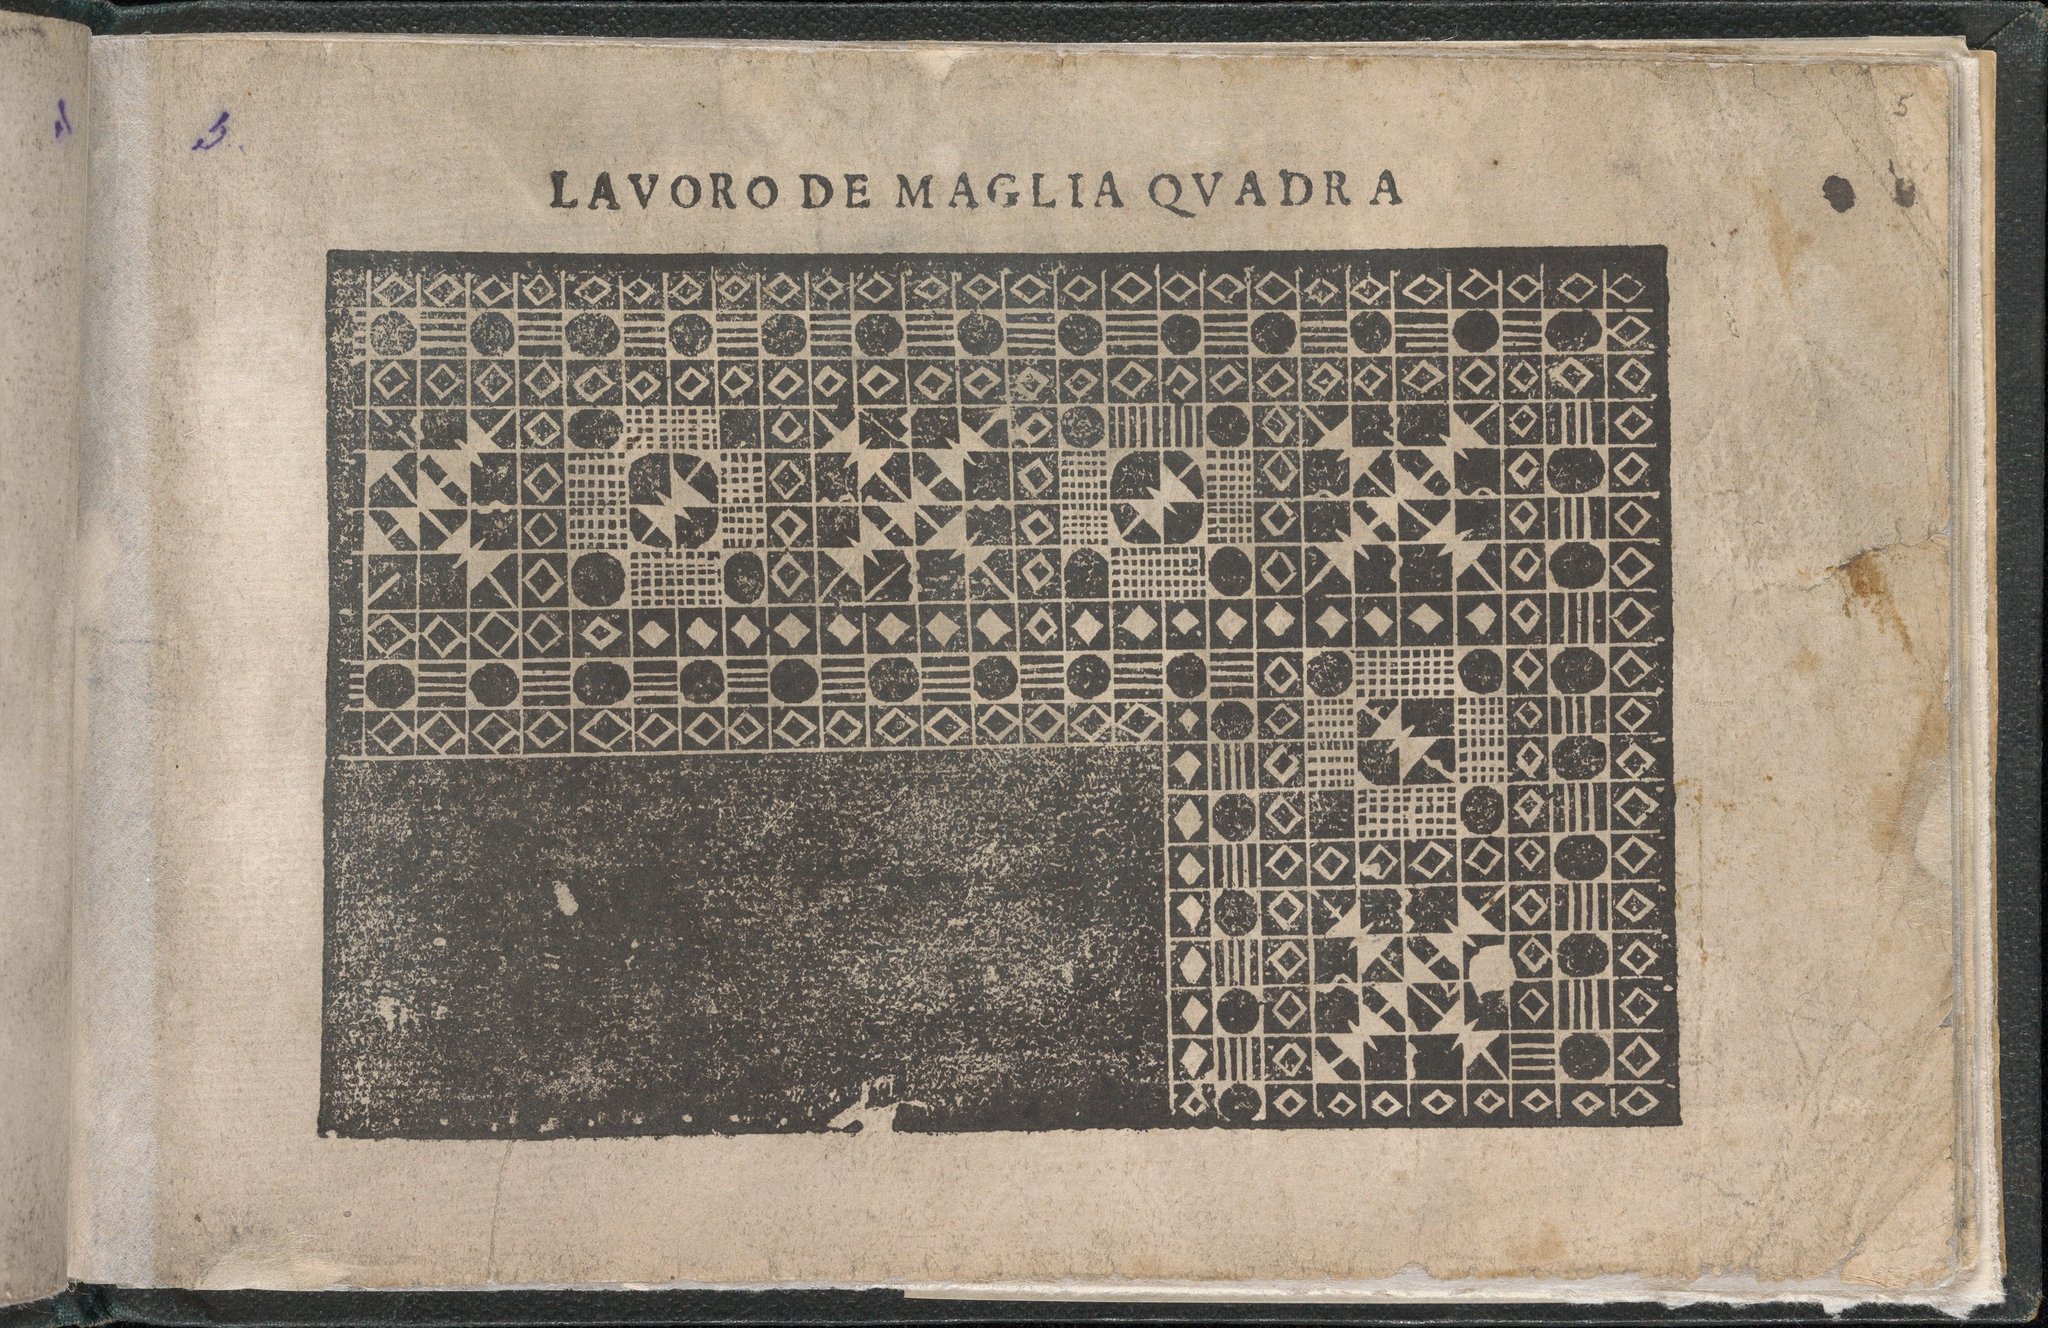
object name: book print ornament architecture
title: Gemma pretiosa della virtuose donne, page 5 (recto)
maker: isabella catanea parasole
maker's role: designer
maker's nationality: italian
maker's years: 1565-1625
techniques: woodcut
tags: ornament